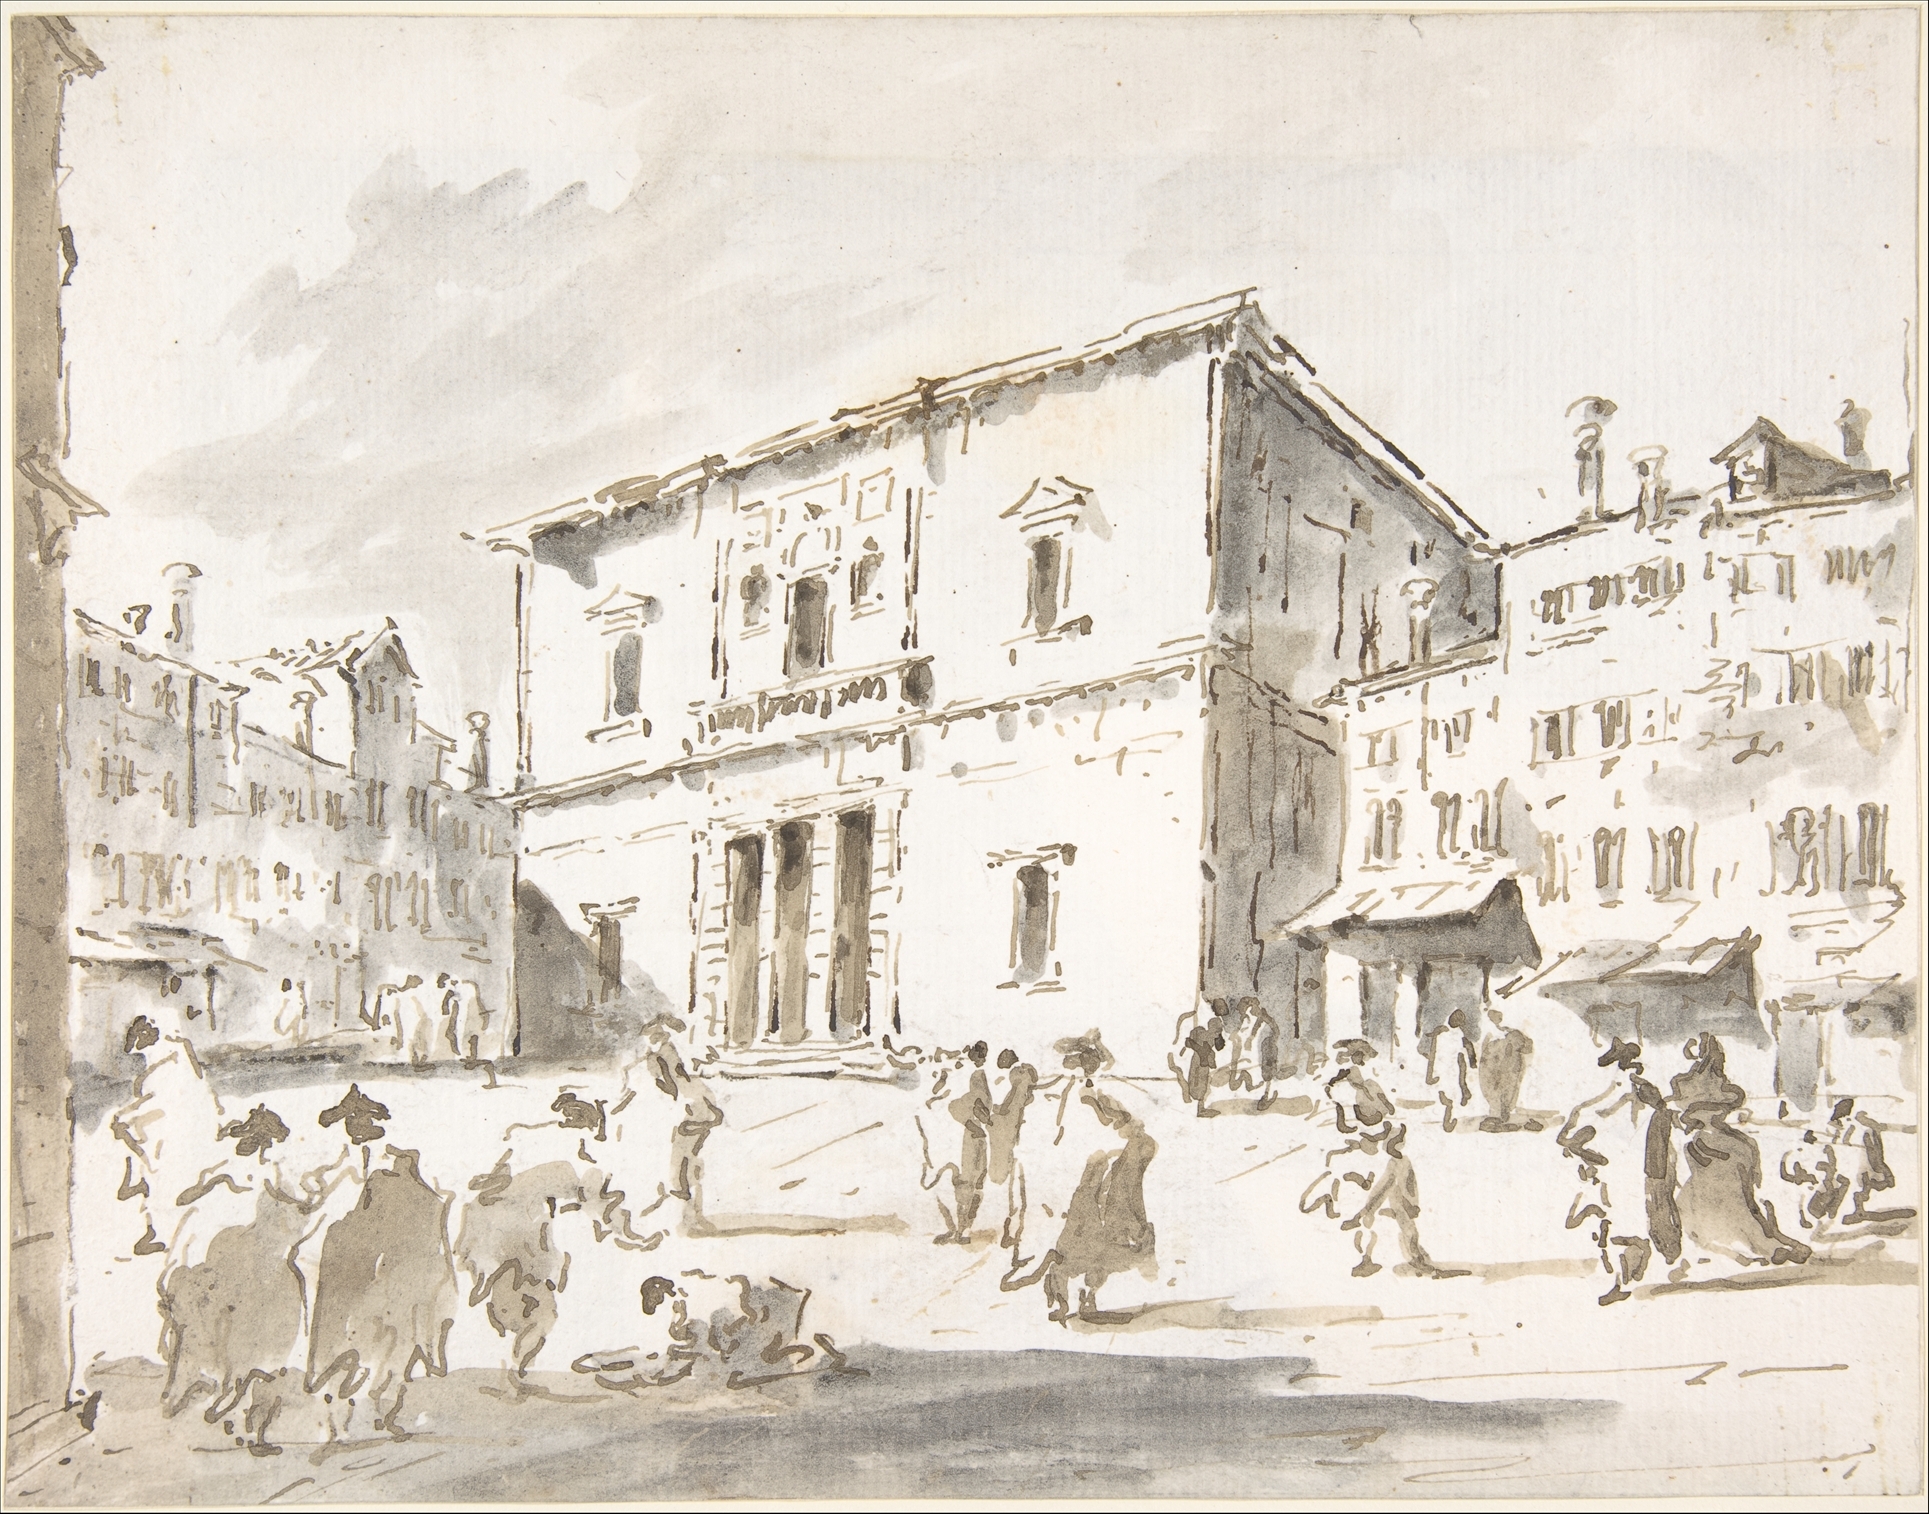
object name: drawing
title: The Fenice Theater in Venice (recto); Fragment of a Larger Drawing Representing Part of a Column and a Cornice (verso)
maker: francesco guardi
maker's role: artist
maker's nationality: italian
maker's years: 1712-1793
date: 1712-1835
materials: chalk, ink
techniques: brush, pen, wash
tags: human figures,buildings,venice